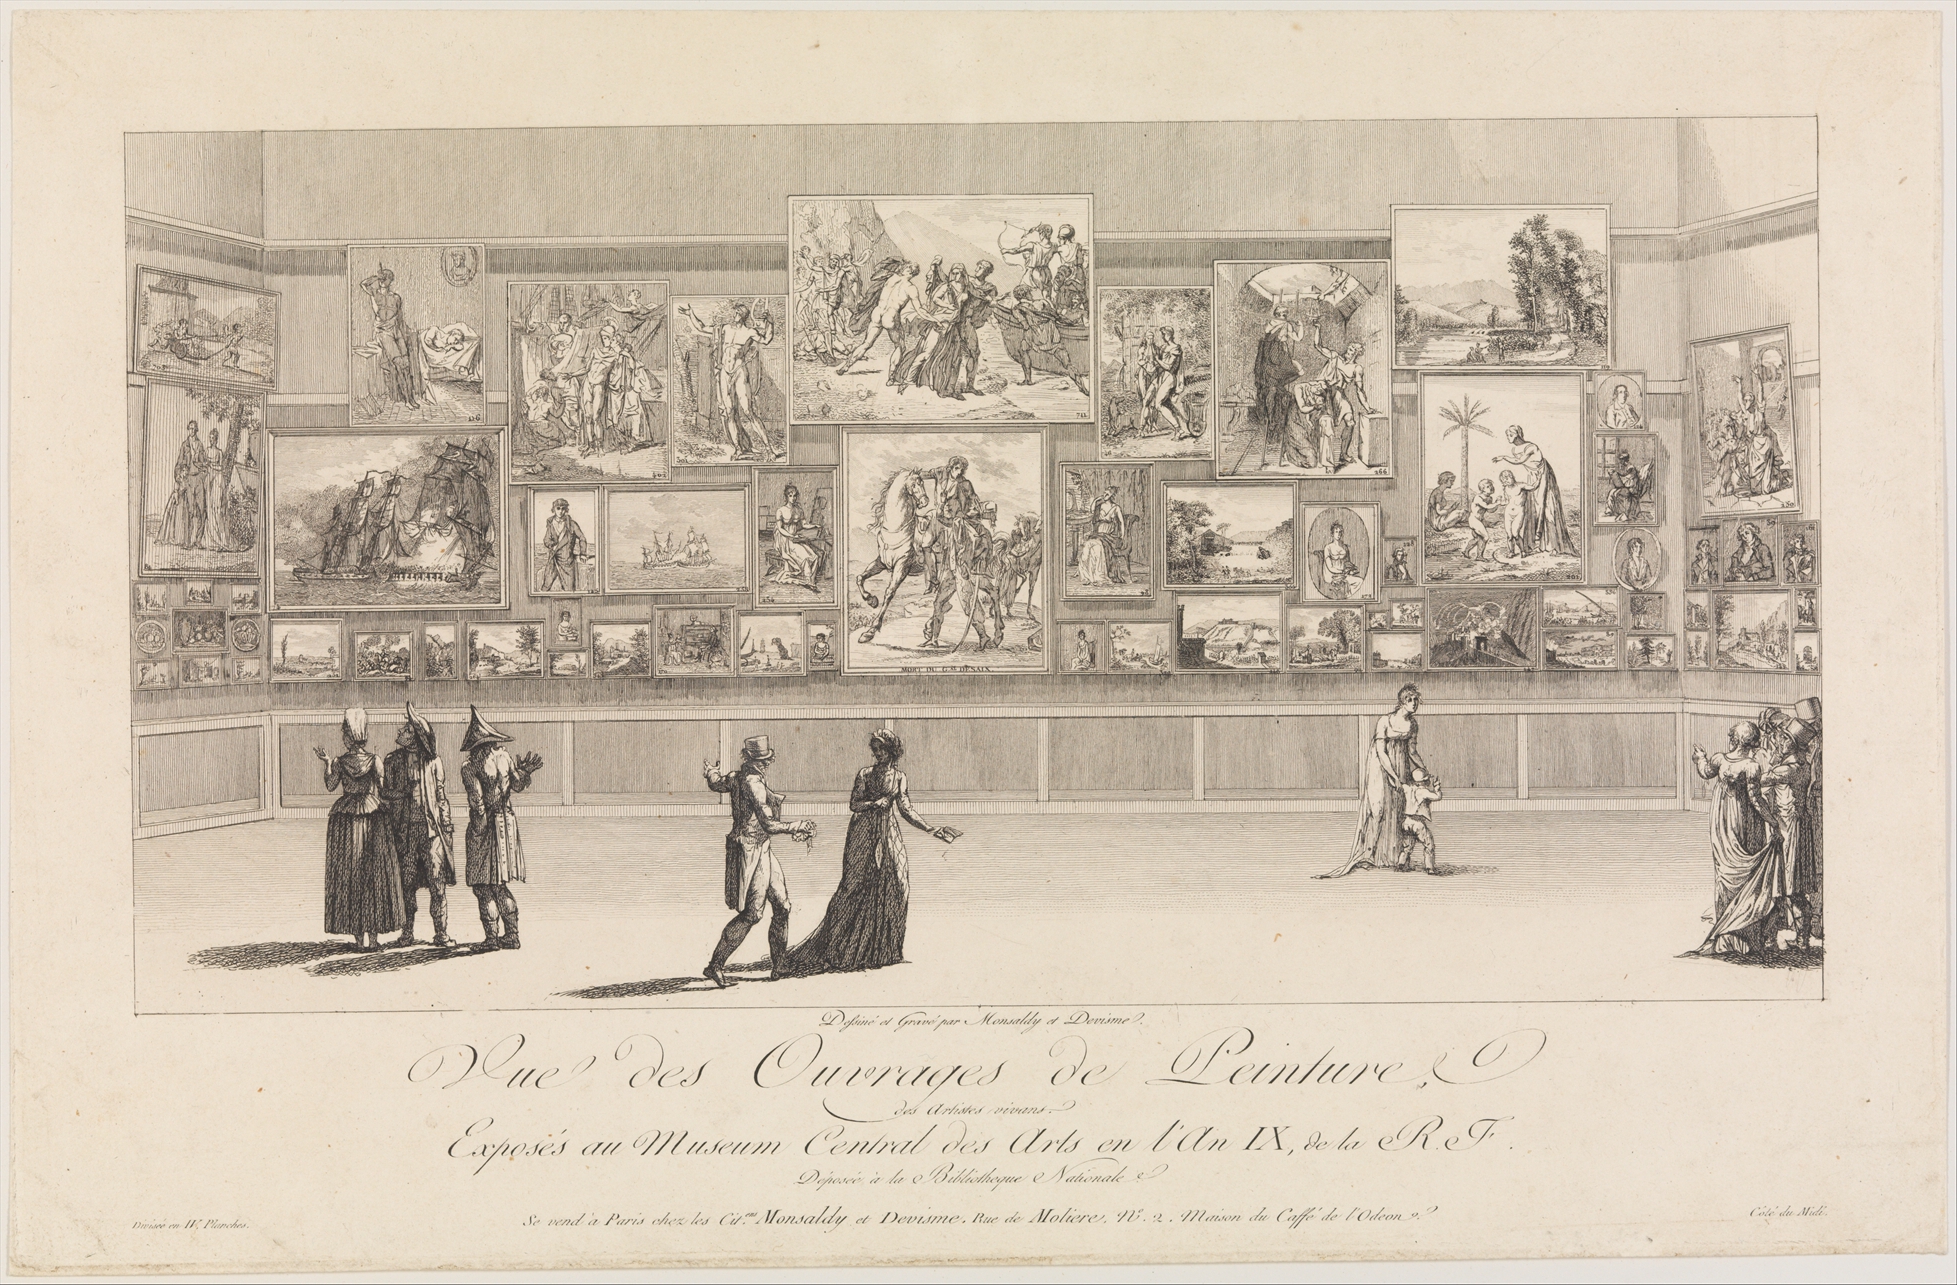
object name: print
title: Vue des Ouvrages de Peinture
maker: antoine maxime monsaldy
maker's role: artist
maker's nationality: french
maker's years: 1768-1816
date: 1801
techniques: etching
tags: men,women,horses